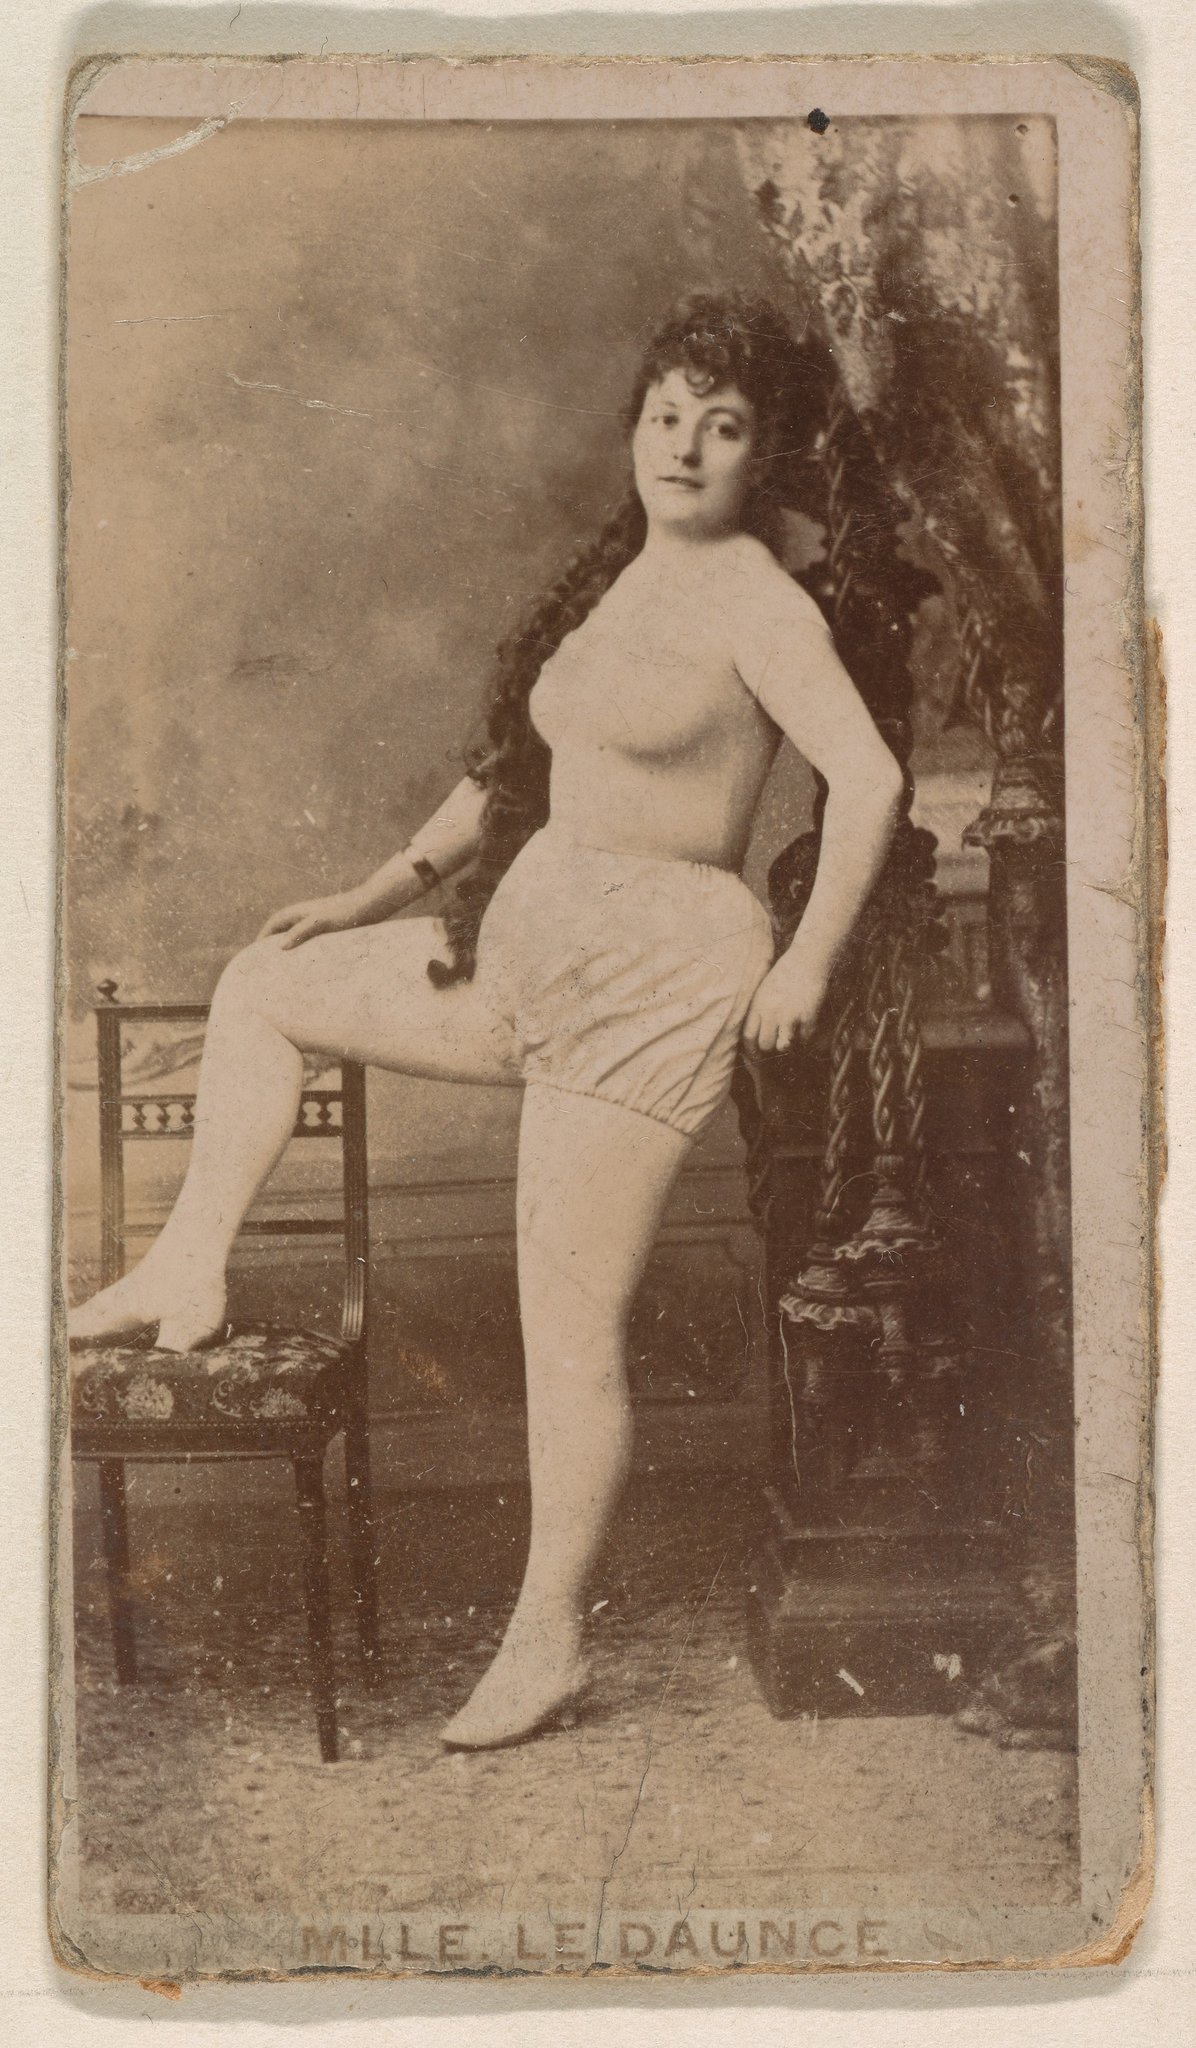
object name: photograph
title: Mlle. Le Daunce, from the Actresses series (N245) issued by Kinney Brothers to promote Sweet Caporal Cigarettes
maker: kinney brothers tobacco company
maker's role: publisher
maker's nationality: american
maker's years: 1869-2011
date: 1890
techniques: albumen silver print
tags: portraits,women,actresses